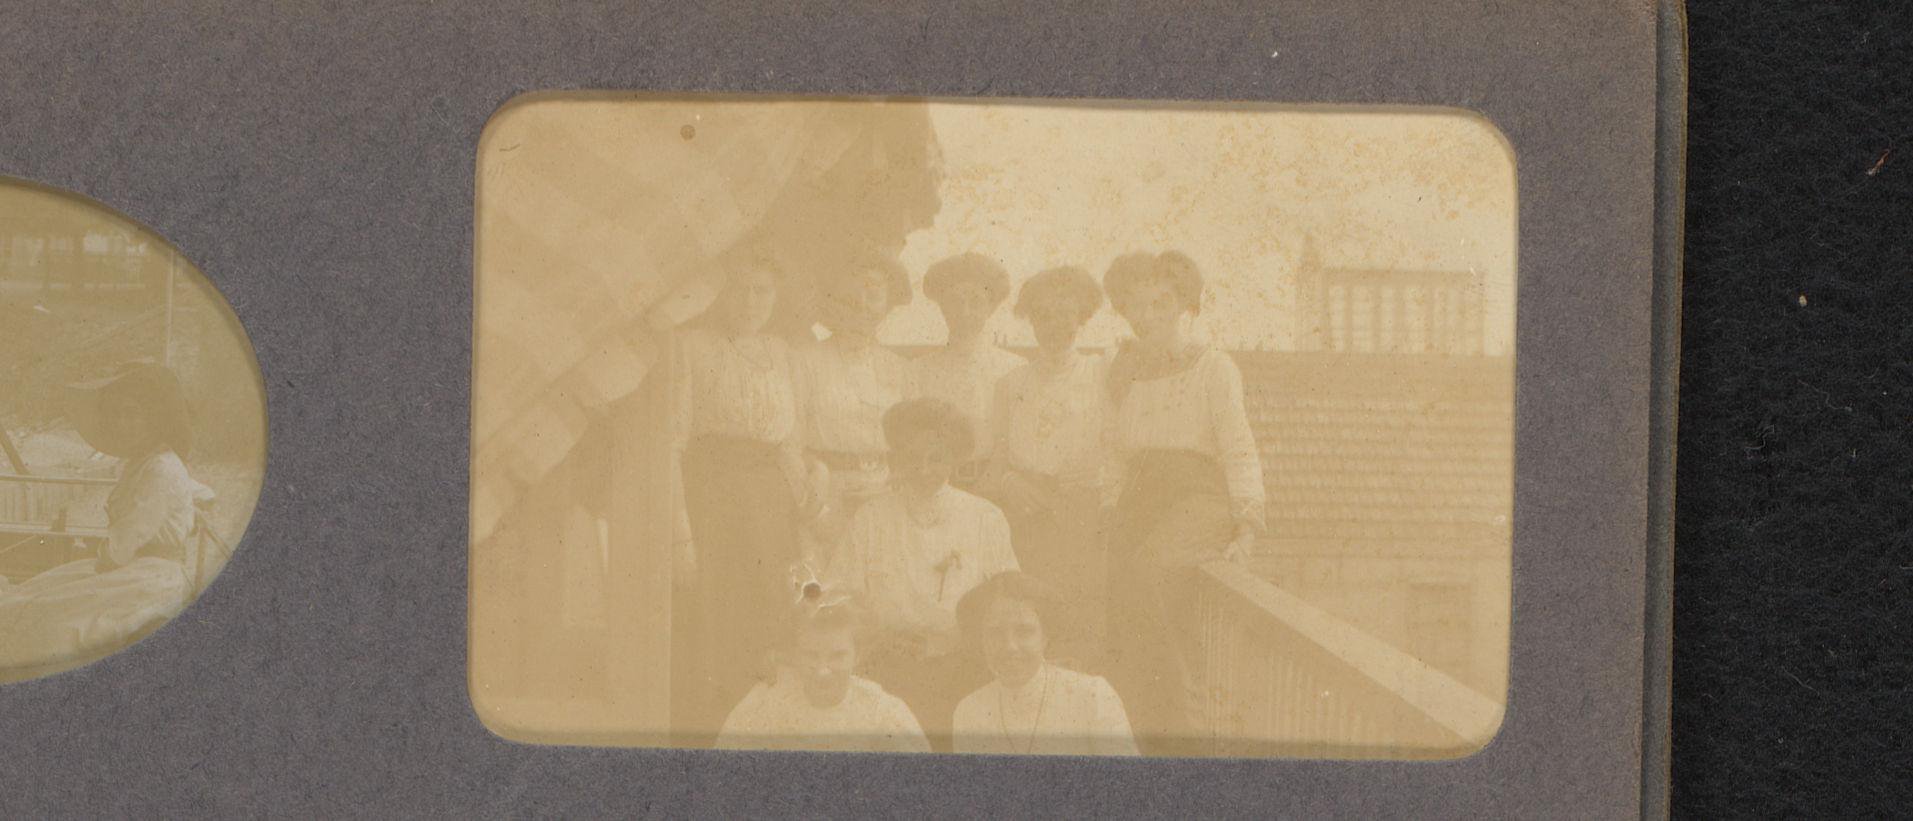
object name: photograph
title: Groepsportret met acht jonge vrouwen, schoolklas van Mej. v/d Velde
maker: Anonymous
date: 1907-1911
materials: paper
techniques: gelatin silver print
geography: gelderland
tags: adolescent, young woman, maiden, anonymous historical persons portrayed in a group, in a group-portrait, gelderland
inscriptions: inscription: ‘Cursus Hollandsch. Zomer 1911.’